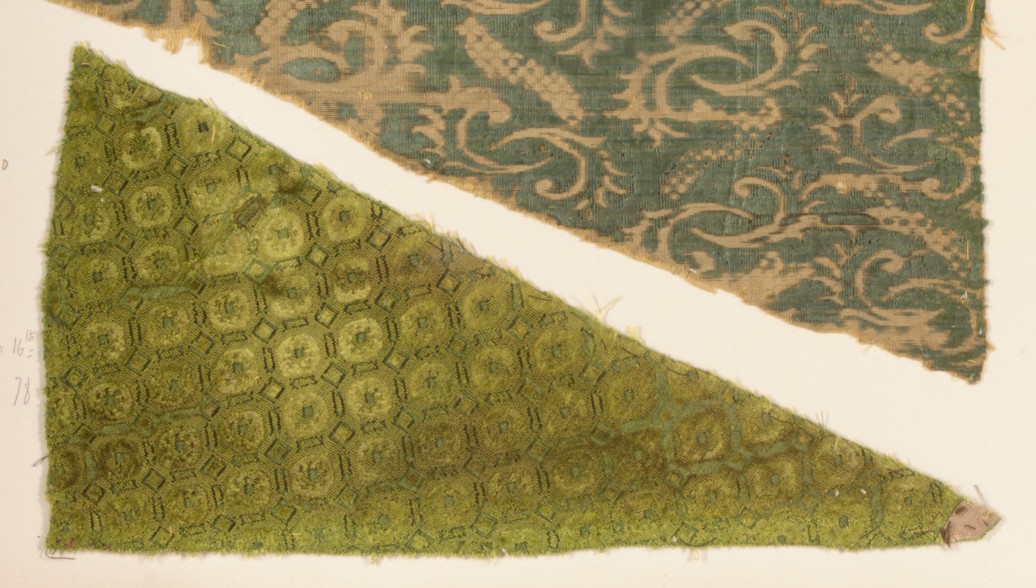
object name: fragment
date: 1567-1633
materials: silk